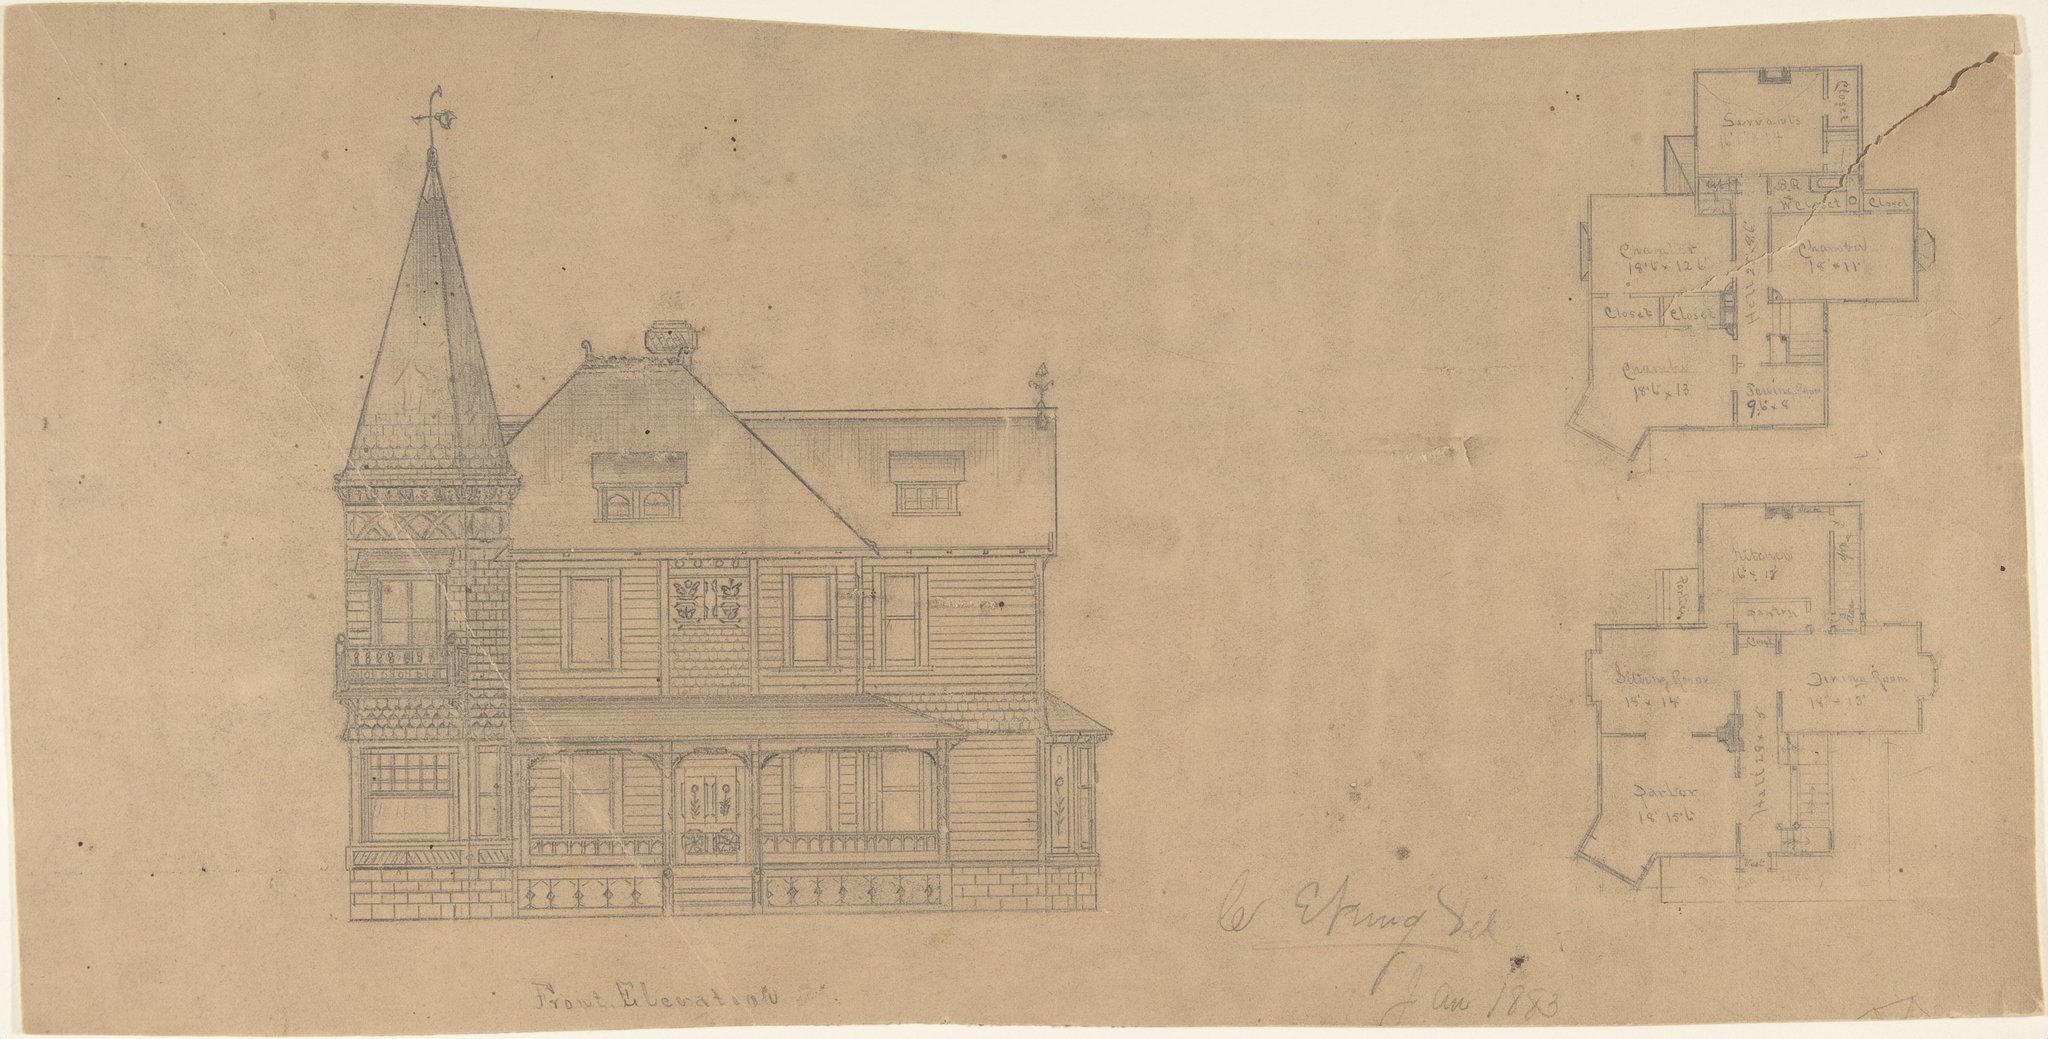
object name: drawing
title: Design for a House, Front Elevation and Plans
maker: w. strong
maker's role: artist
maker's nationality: british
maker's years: 19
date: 1883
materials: graphite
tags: houses